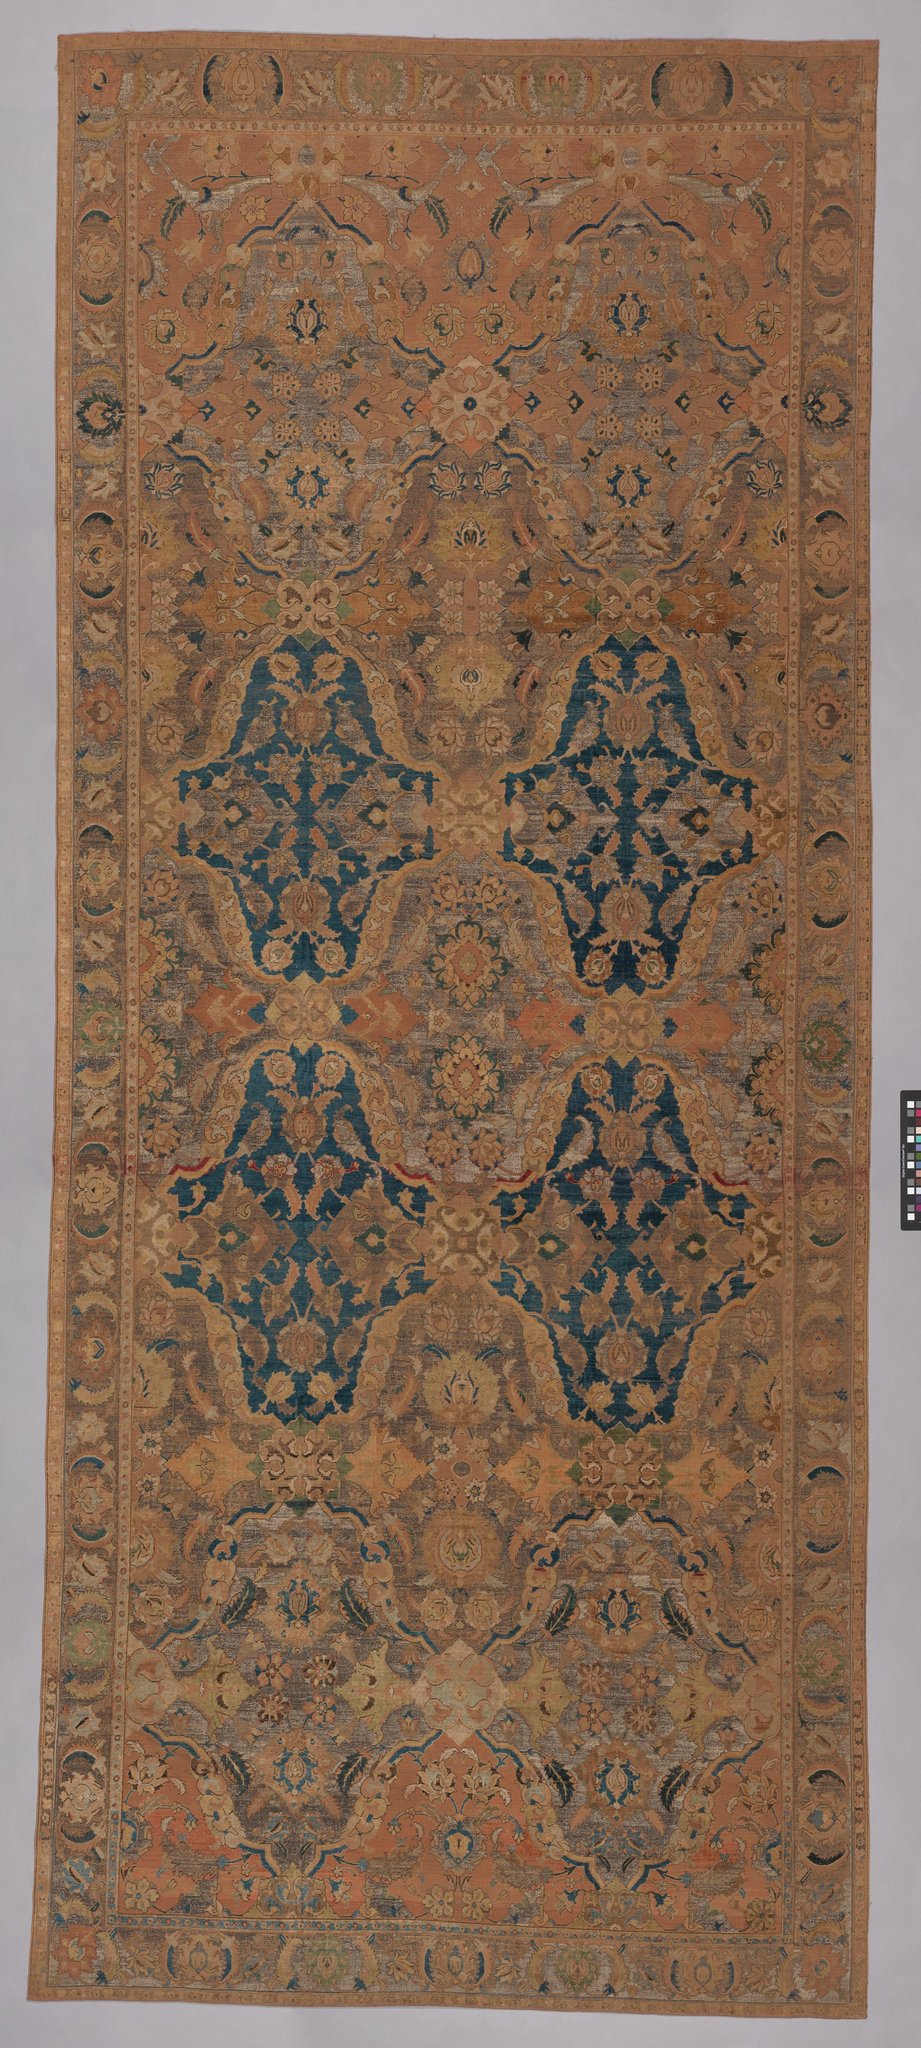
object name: carpet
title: 'Polonaise' Carpet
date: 1601-1650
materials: cotton, metal thread, silk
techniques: asymmetrically knotted pile, brocade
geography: iran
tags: flowers